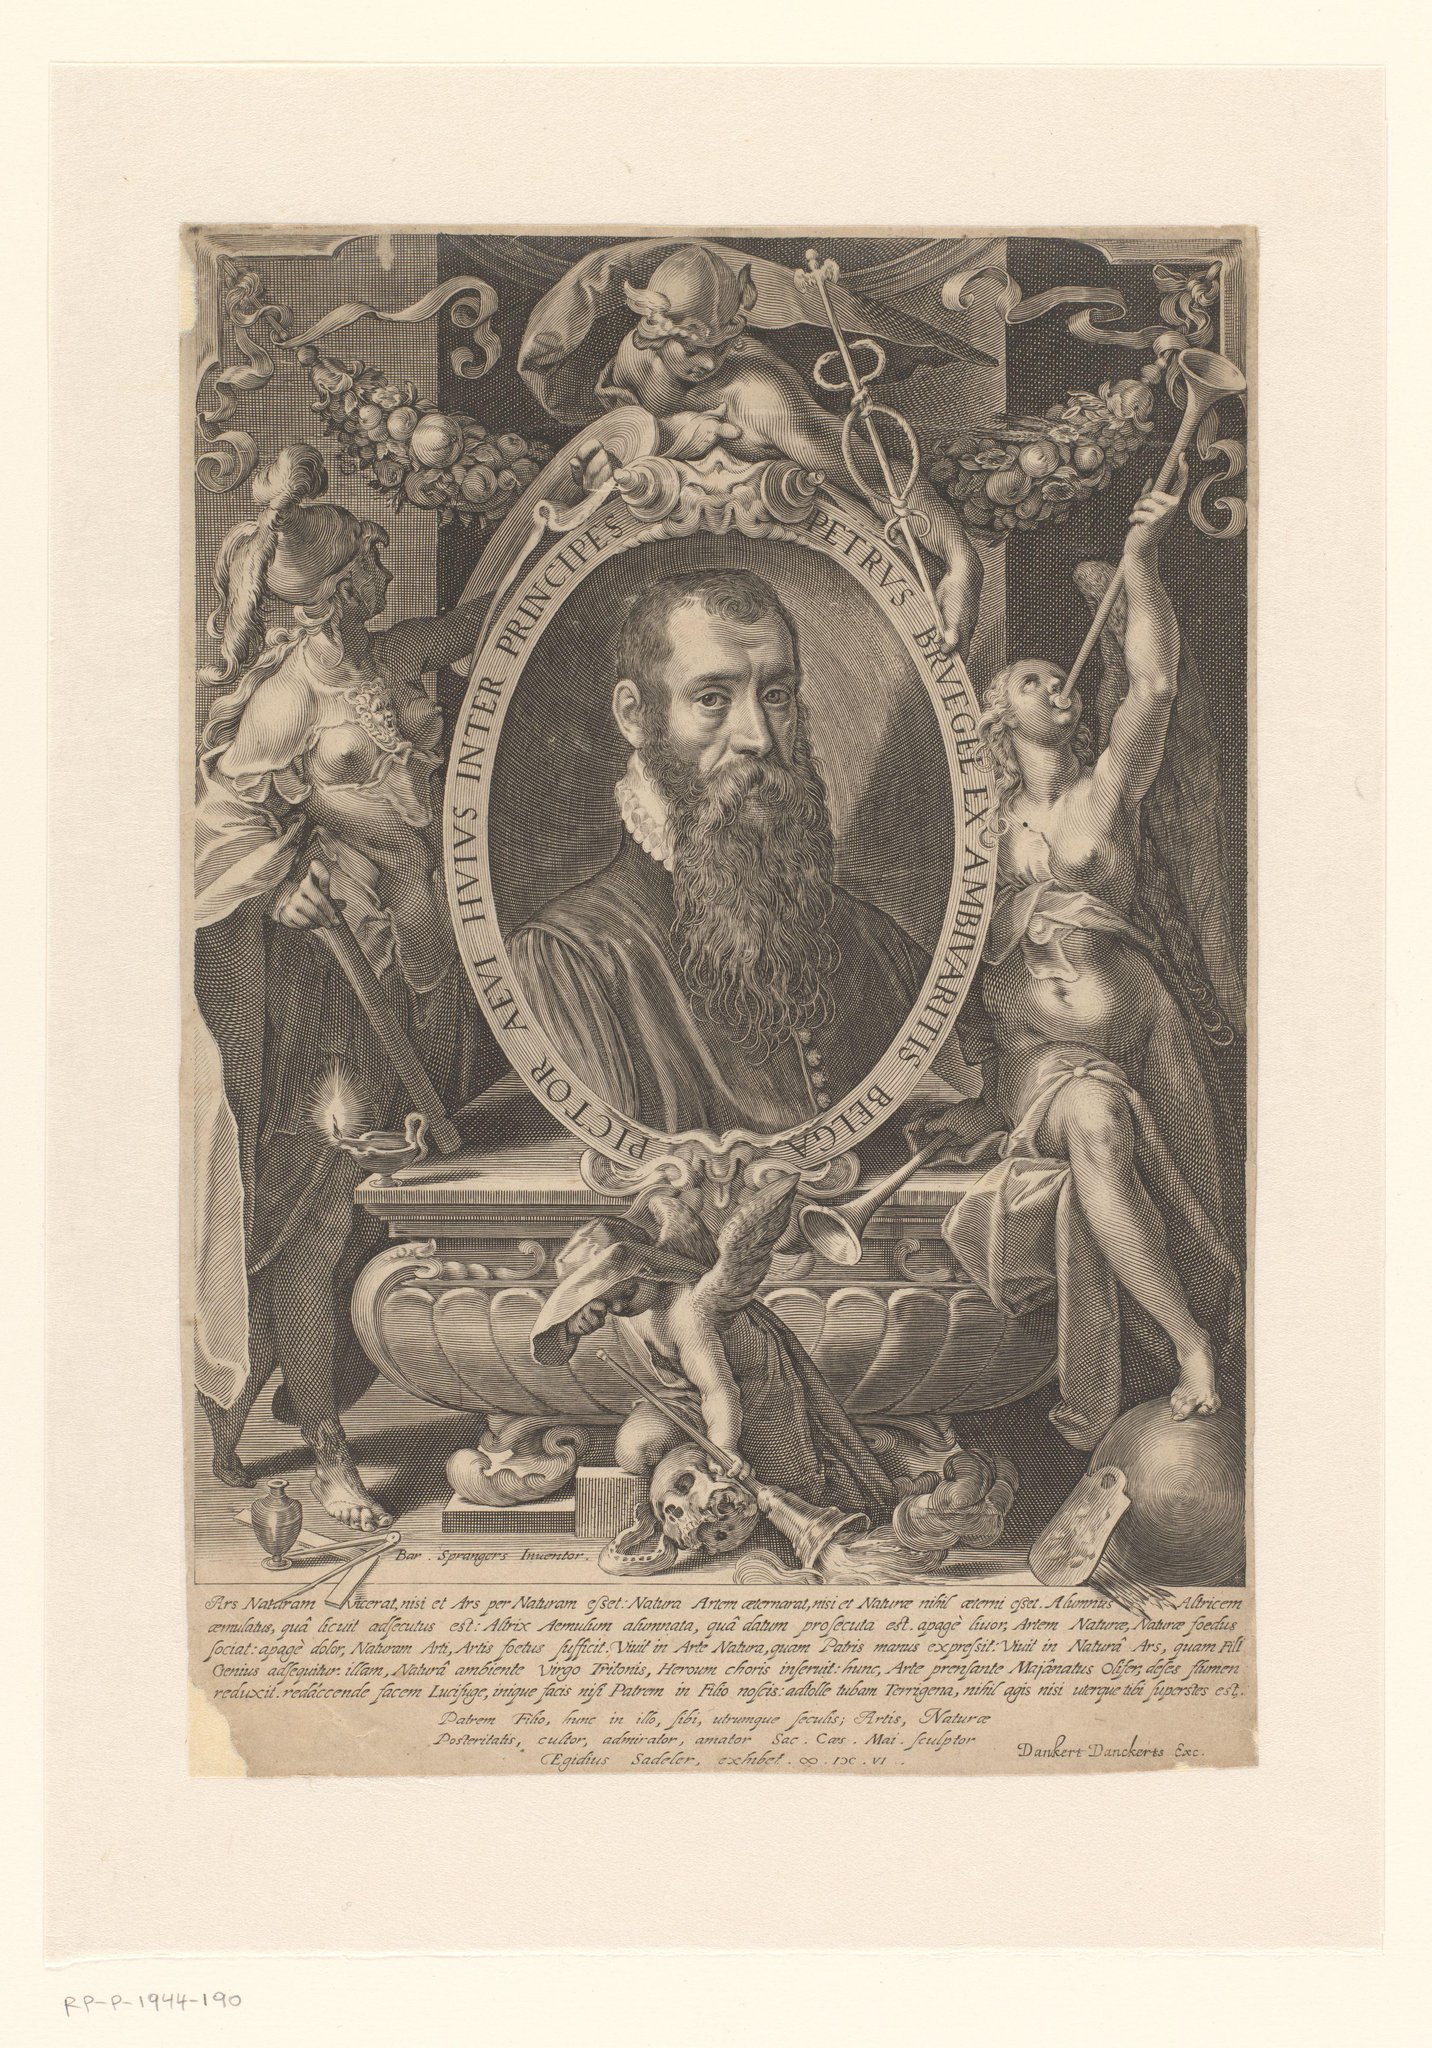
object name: print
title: Portret van Pieter Brueghel de Jonge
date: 1606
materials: paper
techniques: engraving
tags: brussels, antwerp, draughtsman, pieter brueghel (ii)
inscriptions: date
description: Pieter Brueghel de Jonge (1564/65-1637/38), schilder, zoon van Pieter Brueghel de Oude. Portret met lange baard in ovale lijst, rustend op een graftombe, omringd door allegorische figuren: Minerva, Fama en Mercurius. Onder het portret een amor met doek over zijn hoofd in gebogen houding, een fakkel omgekeerd houdend, bij een doodshoofd. Aan de voeten van Fama liggen de attributen van de schilderkunst (palet) en penselen). Bij Minerva passer en winkelhaak.